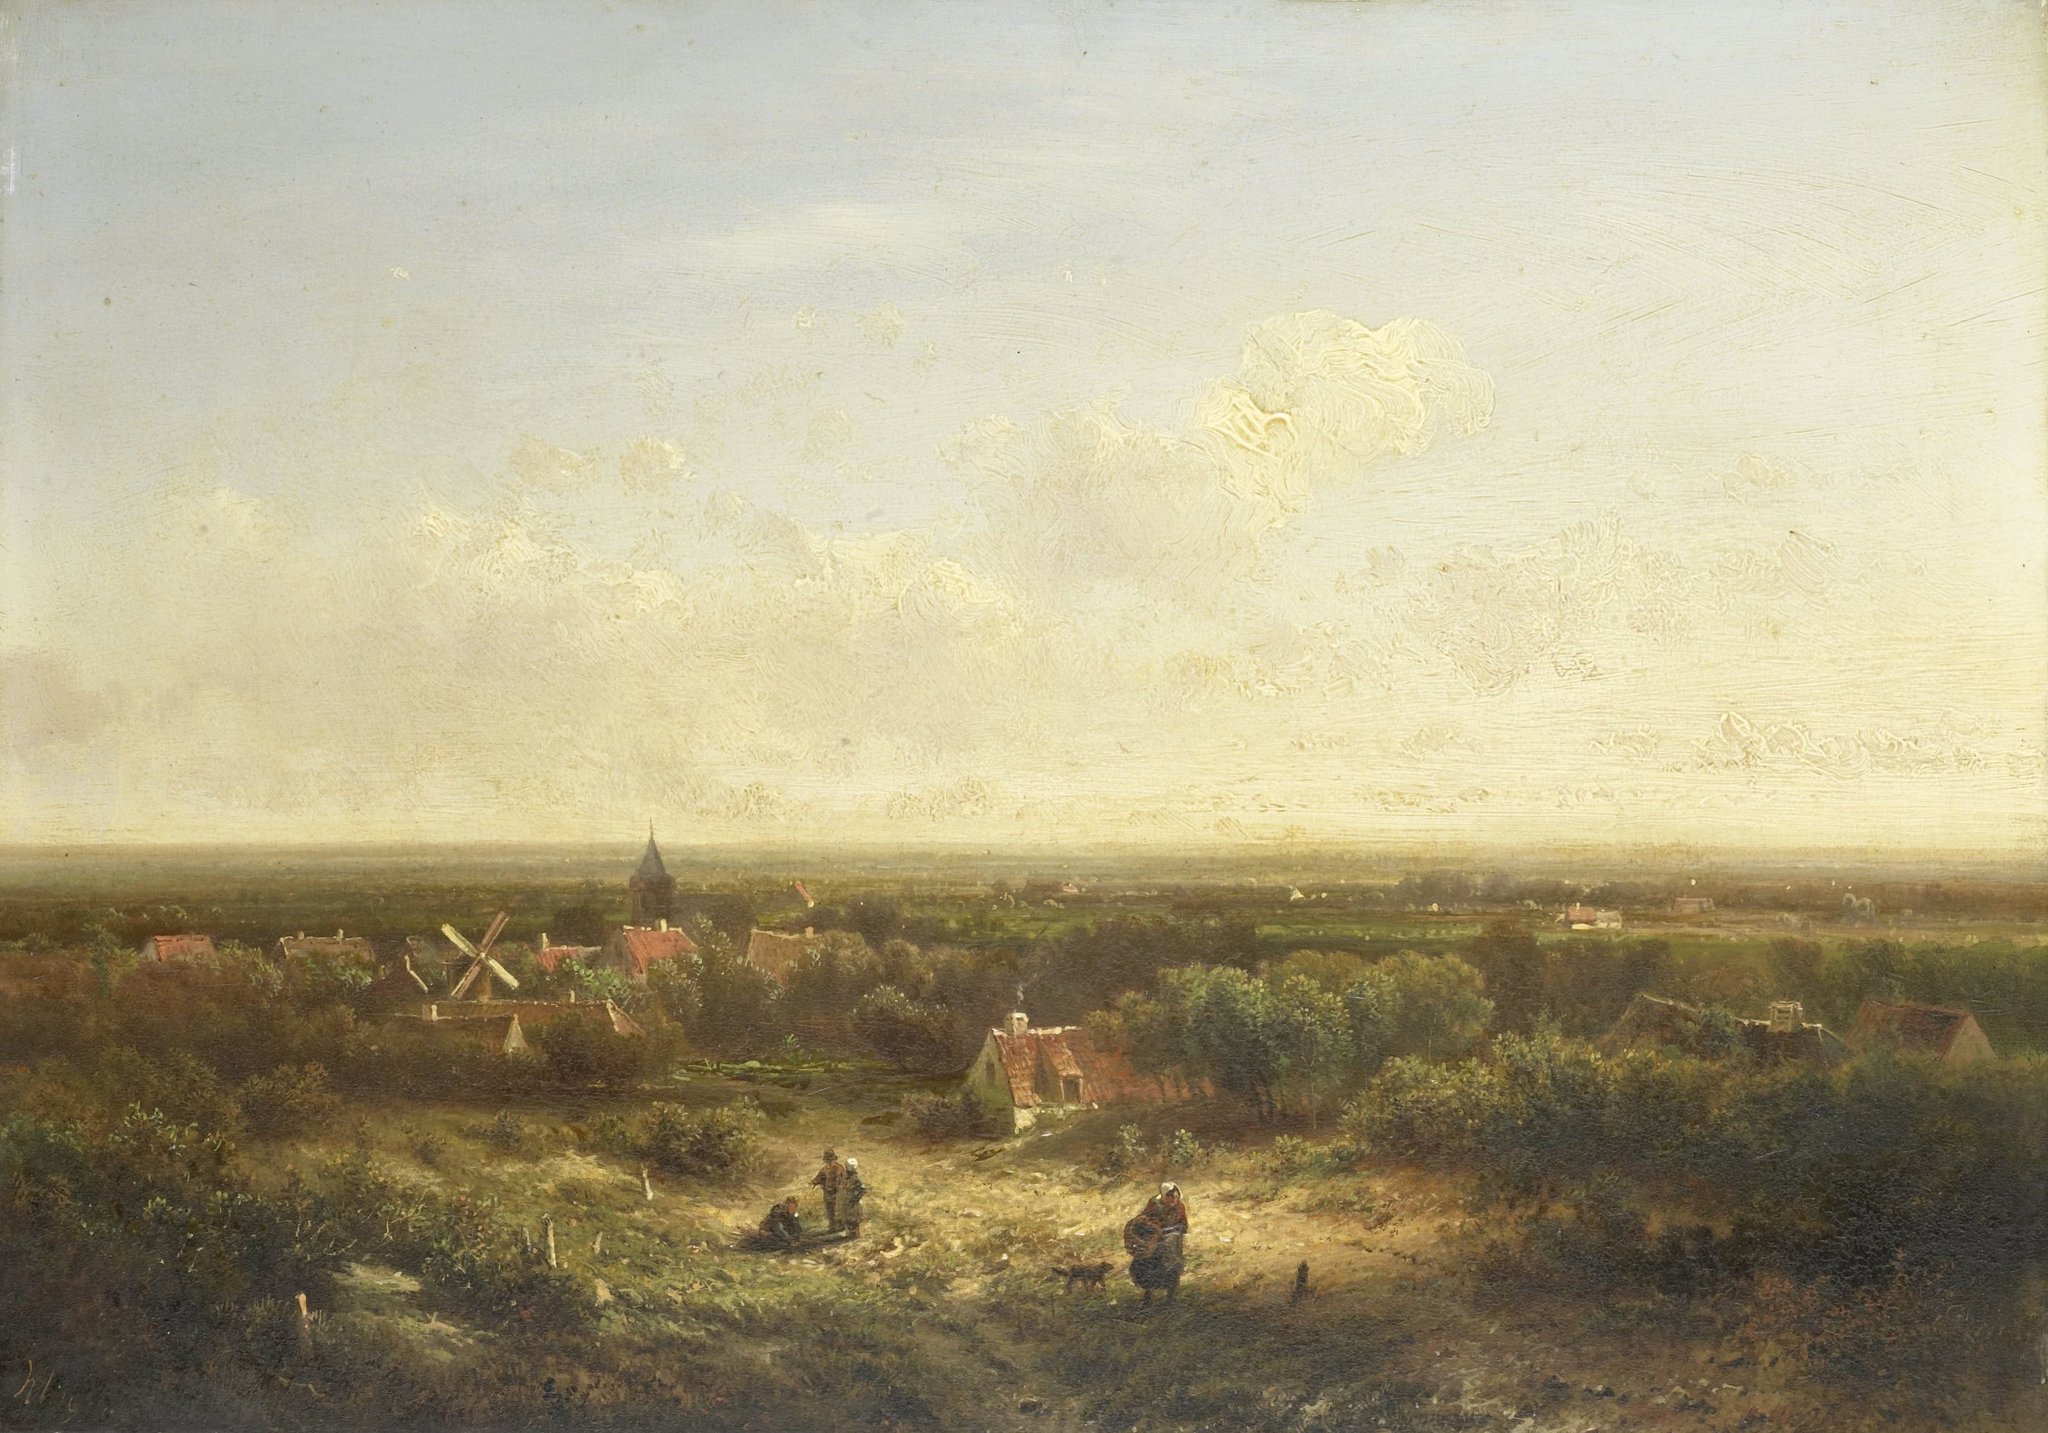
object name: painting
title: Distant View with a Village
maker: pieter lodewijk francisco kluyver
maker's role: painter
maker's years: 1816-1900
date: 1840-1900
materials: oil, panel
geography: netherlands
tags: village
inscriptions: signature: ‘Kluyver’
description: Landschap met een gezicht vanaf een hoger gelegen deel op een dorp met een kerk en molen. Op de voorgrond een weg met enkele figuren.